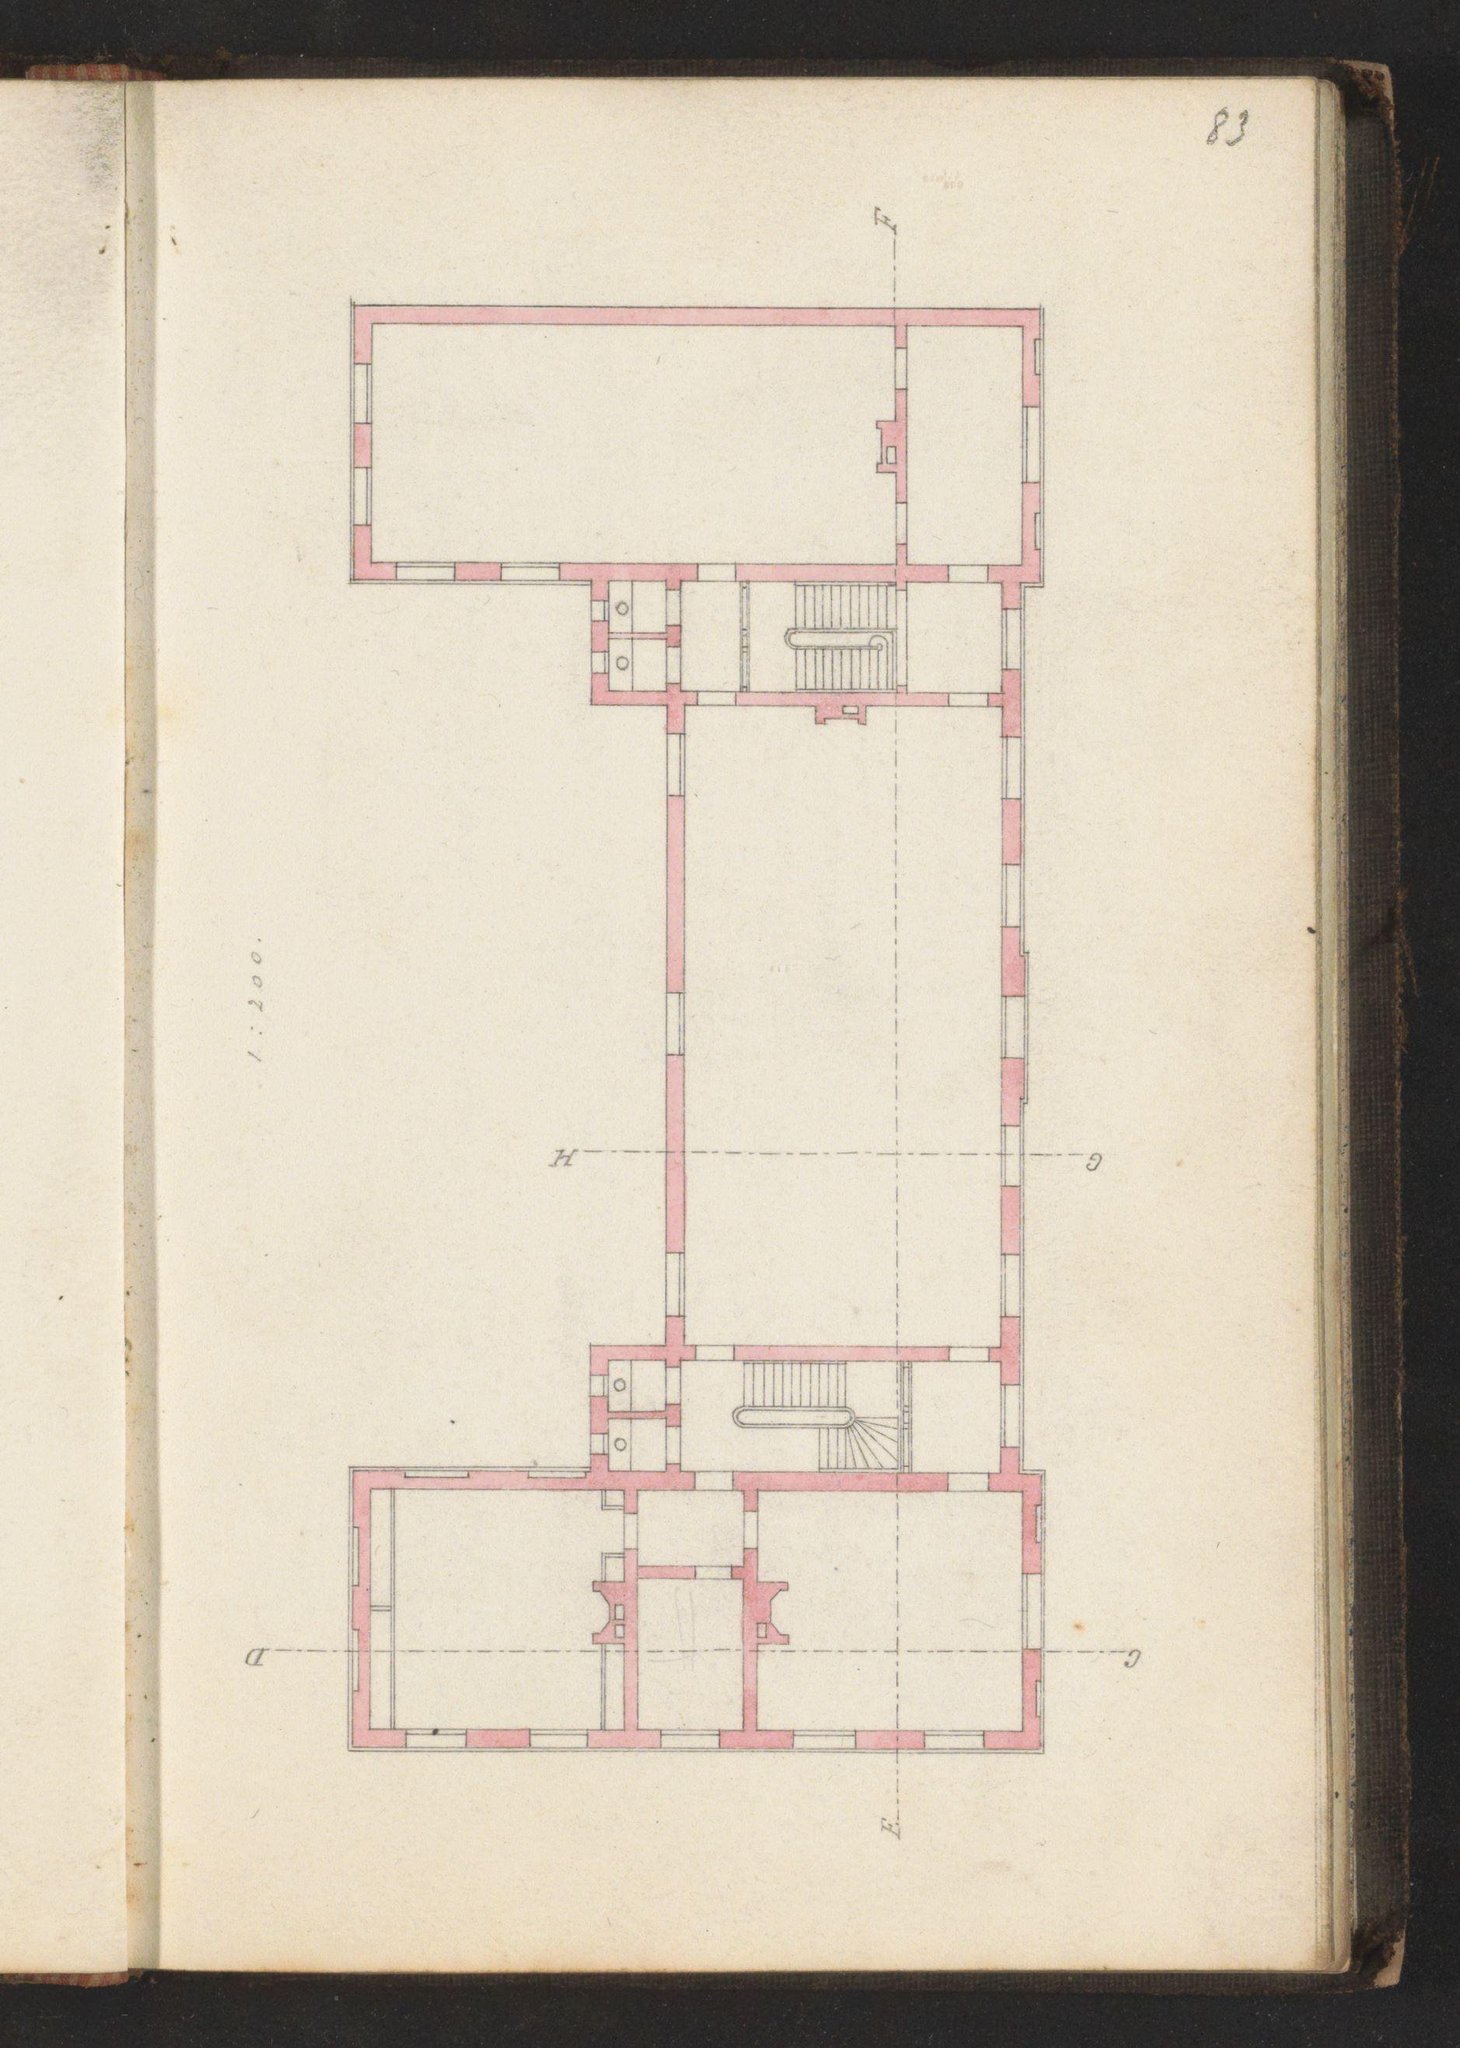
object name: sketchbook leaf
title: Plattegrond van een verdieping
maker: willem springer jr.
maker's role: draughtsman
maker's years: 1815-1907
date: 1864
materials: ink, paper, pencil, watercolor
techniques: brush, pen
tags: plan ~ architecture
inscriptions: annotation: ‘1 : 200./ E/ D/ C/ G/ H/ F’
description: Pagina 83 uit een schetsboek met 164 pagina's.